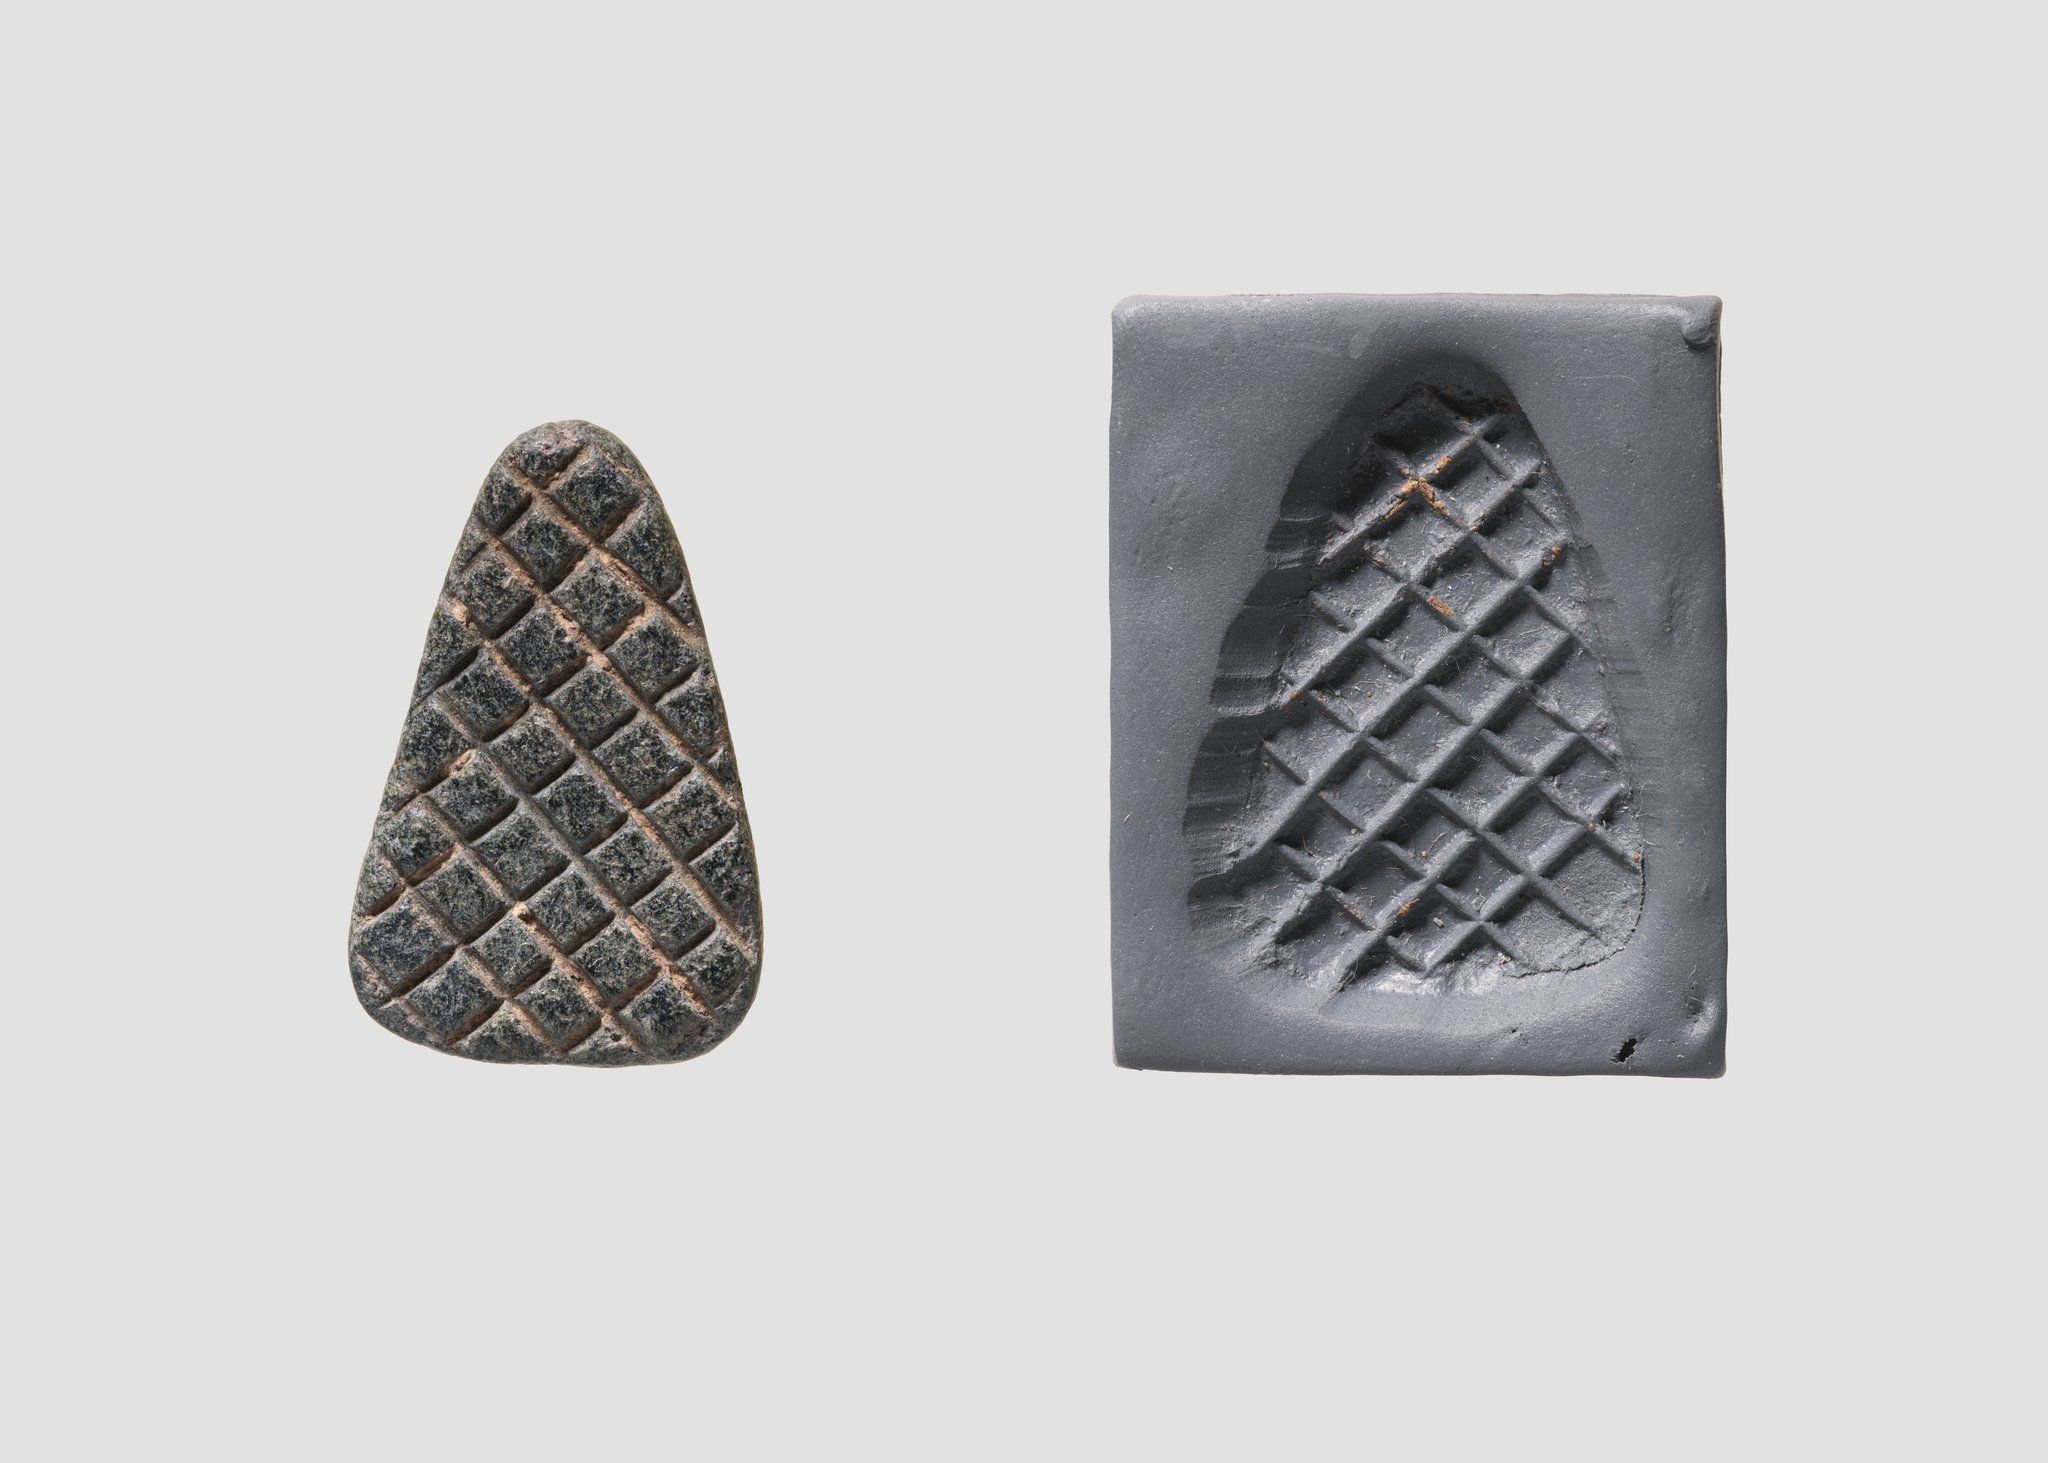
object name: stamp seal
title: Loop-handled wedge shaped stamping device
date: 7000-5001 BCE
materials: mineral, stone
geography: northern syria (?)